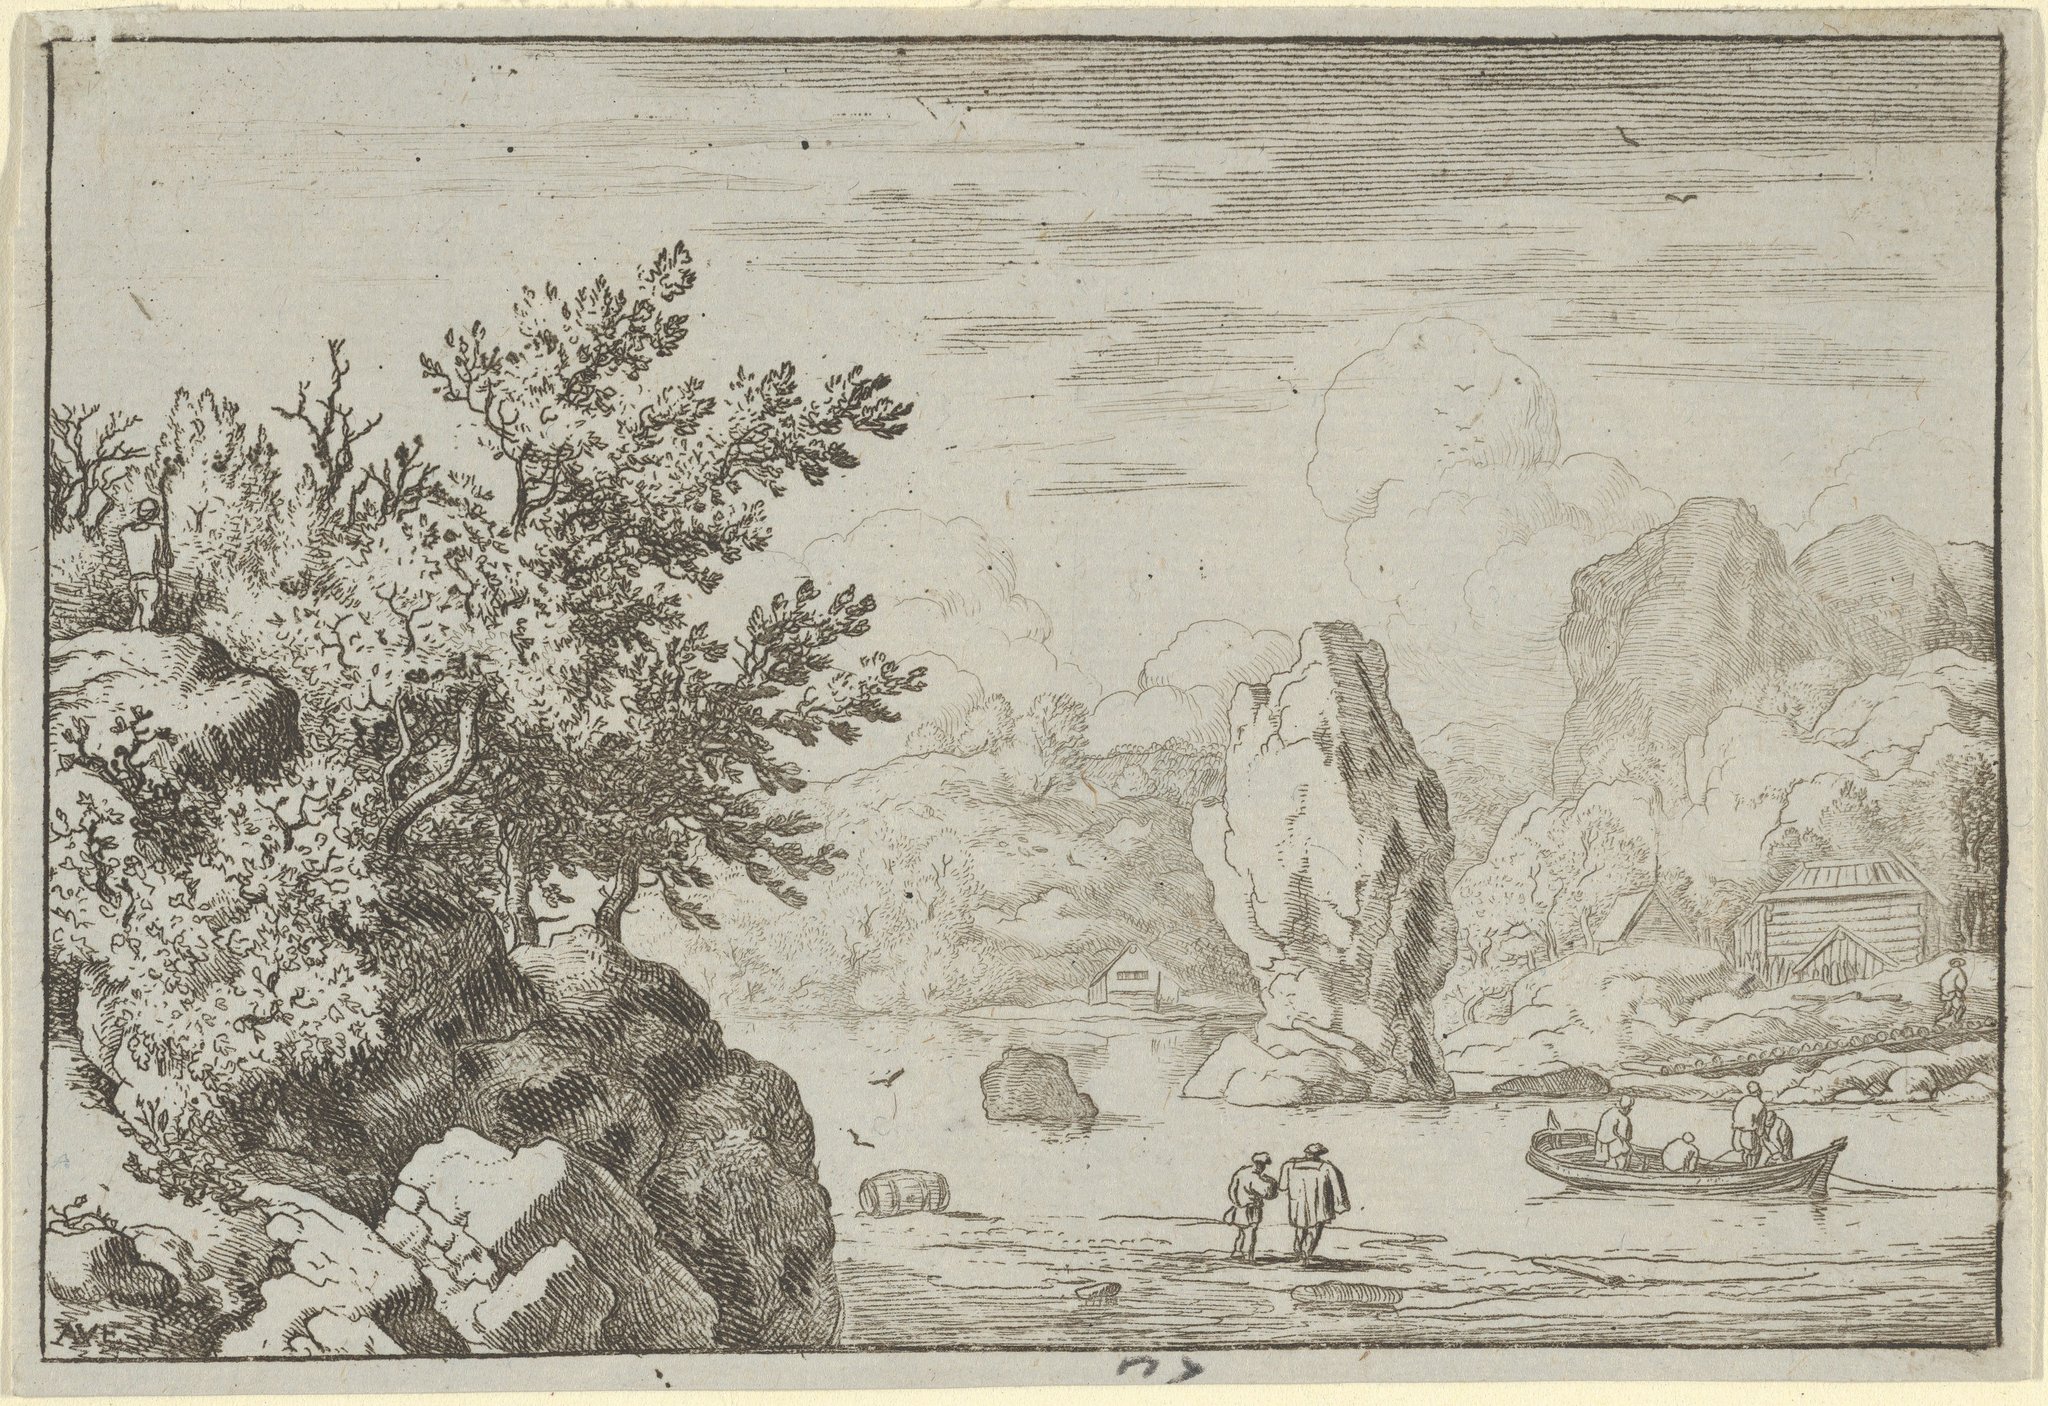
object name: print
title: The Rock in the Middle of the River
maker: allart van everdingen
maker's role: artist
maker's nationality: dutch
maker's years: 1621-1675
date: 1621-1675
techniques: engraving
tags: men,rivers,boats